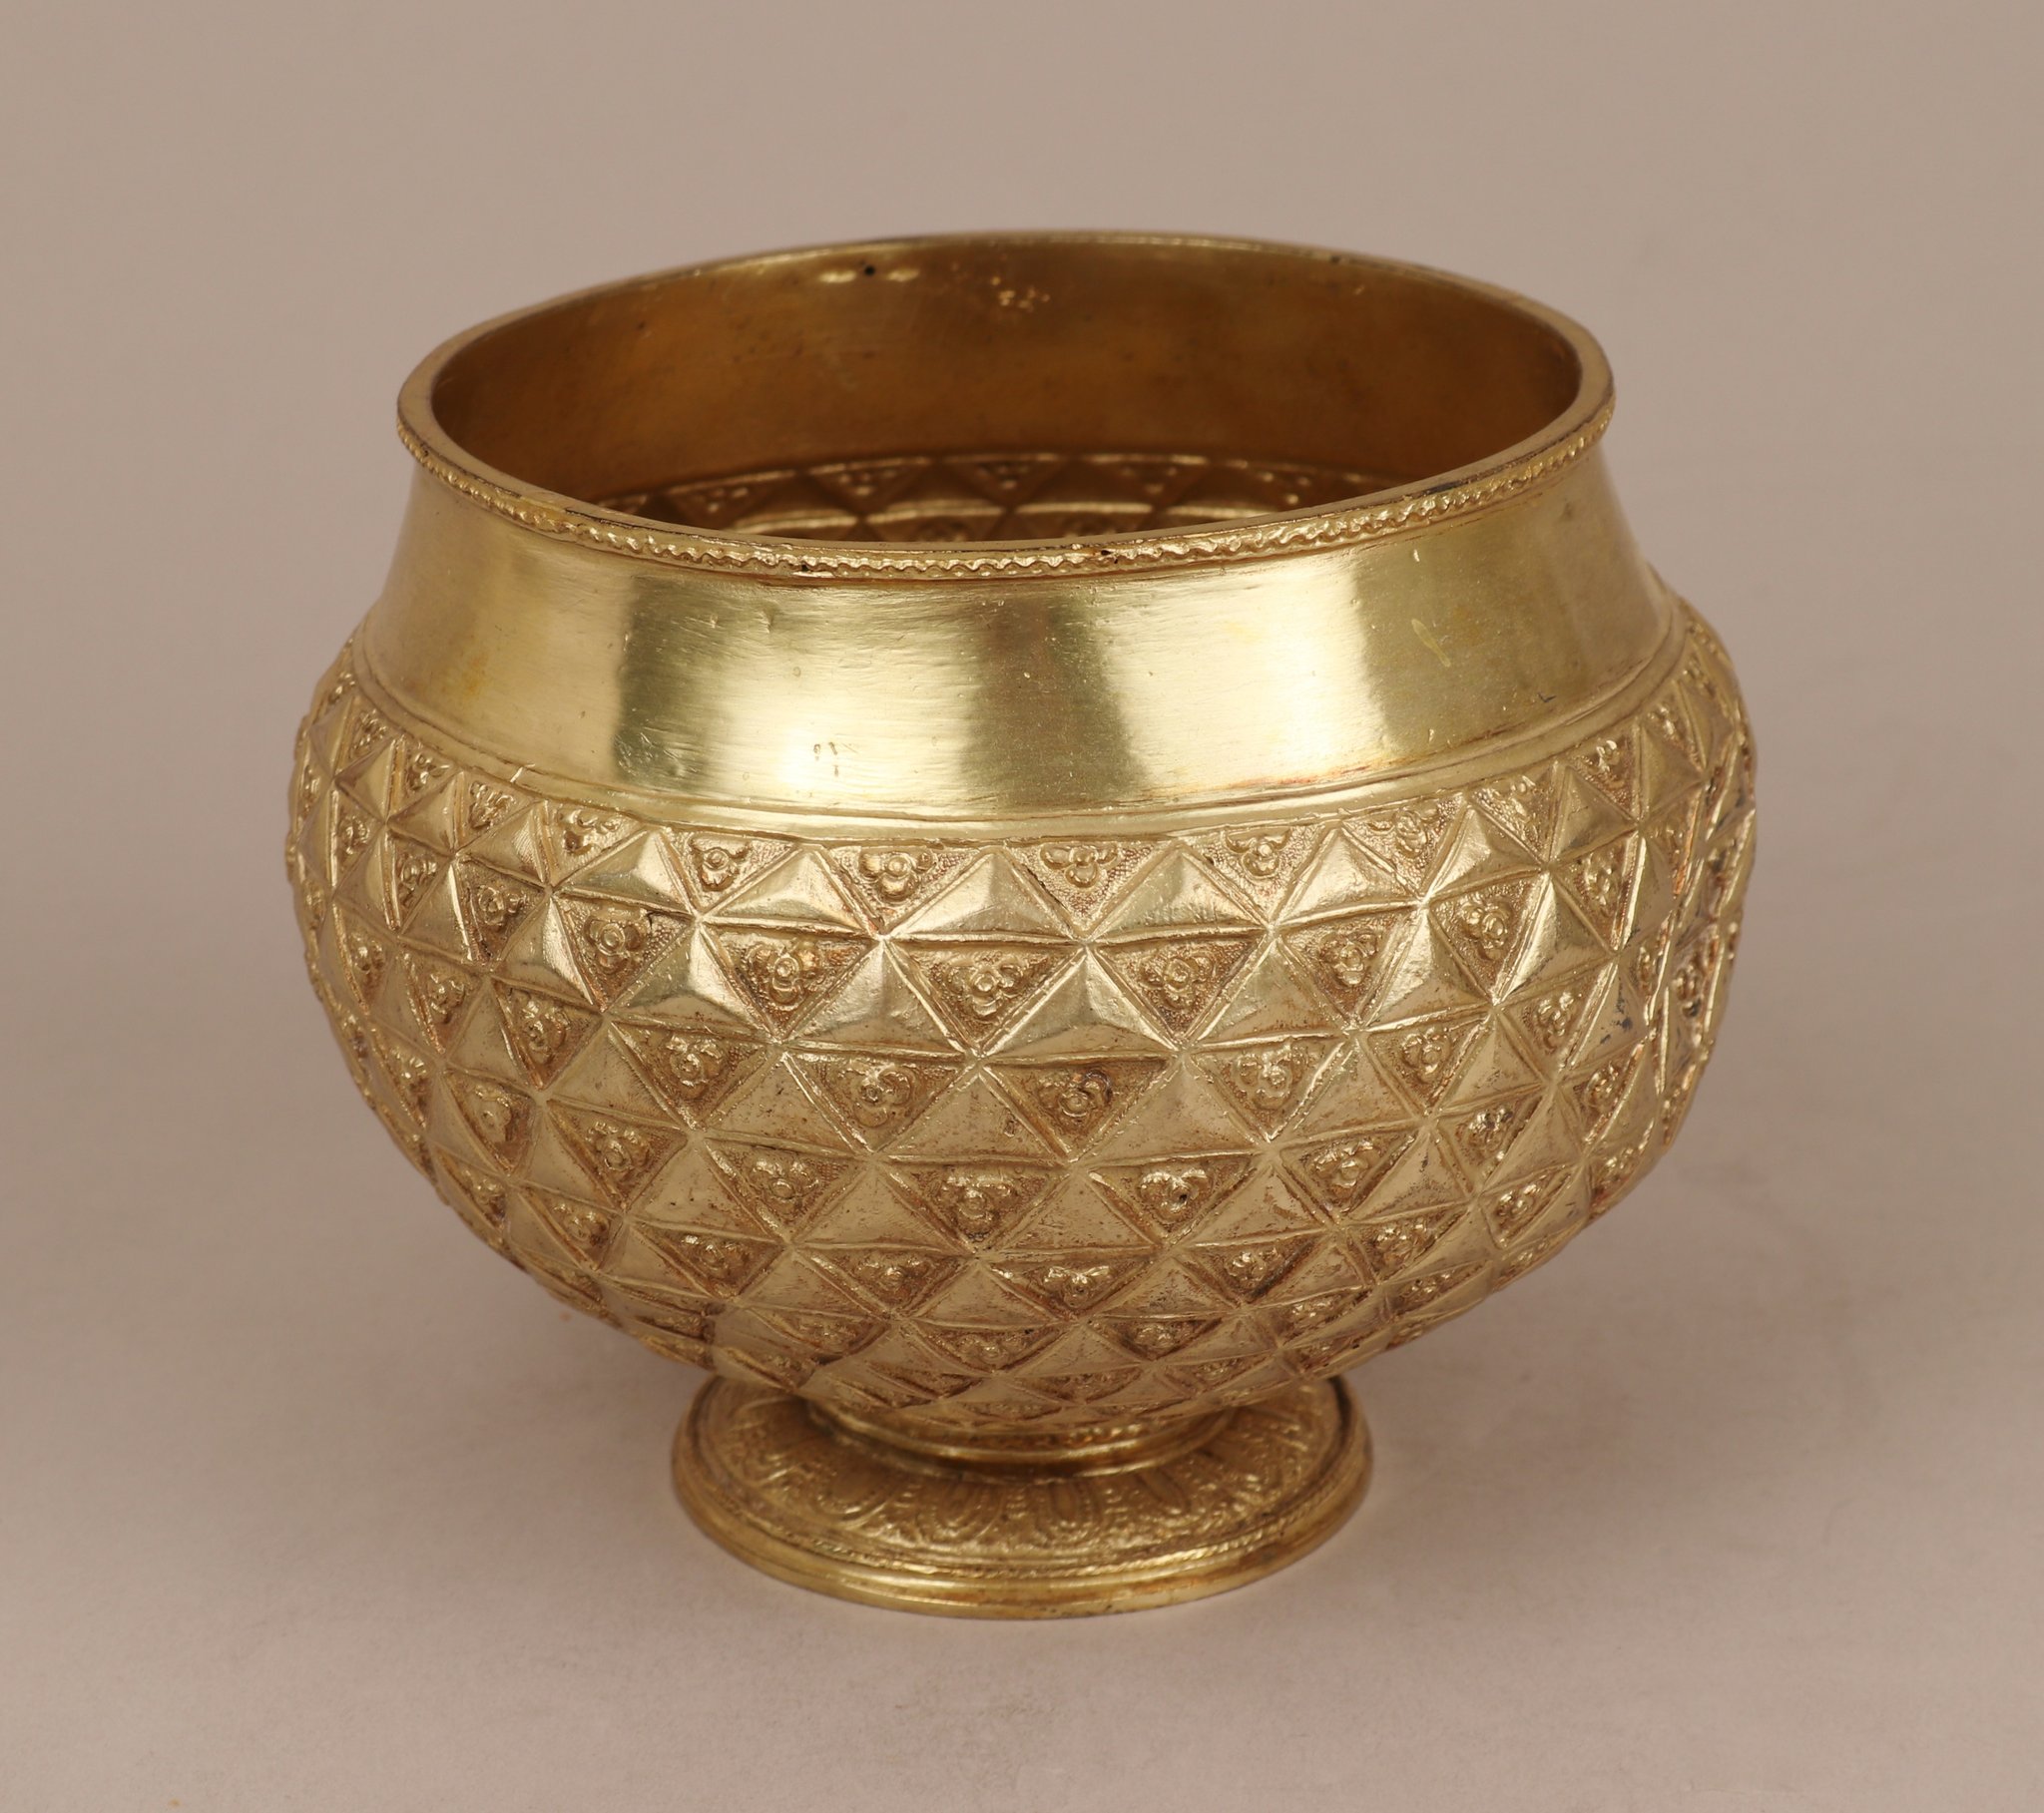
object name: bratina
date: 1801-1900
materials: gilt, silver